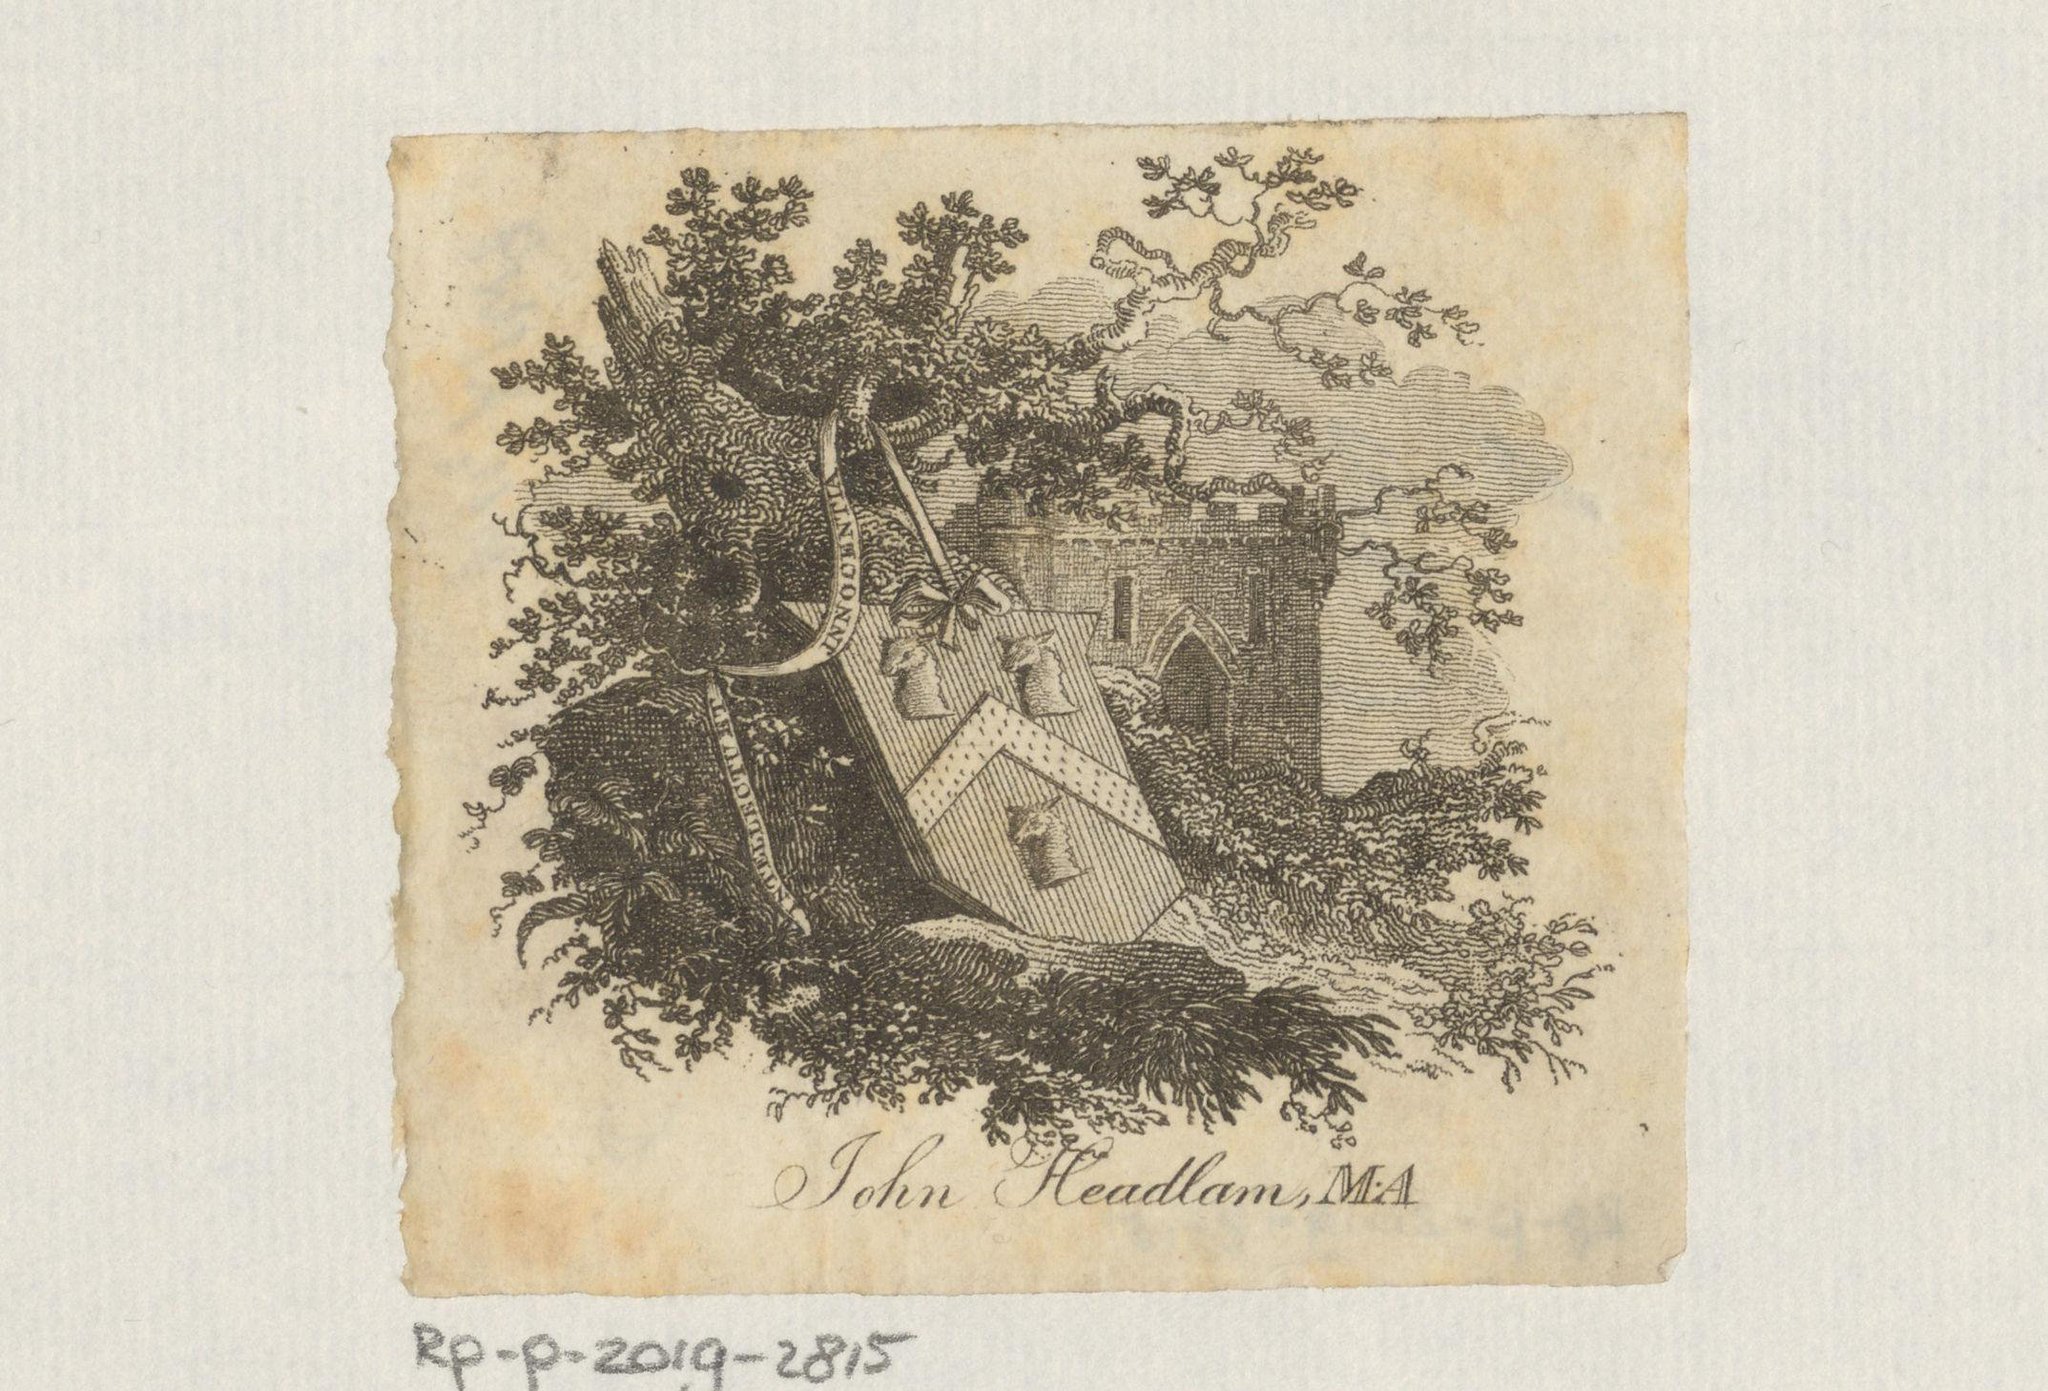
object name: bookplate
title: Intellectu et innocentia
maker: Anonymous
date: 1780-1854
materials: paper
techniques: etching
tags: armorial bearing, heraldry